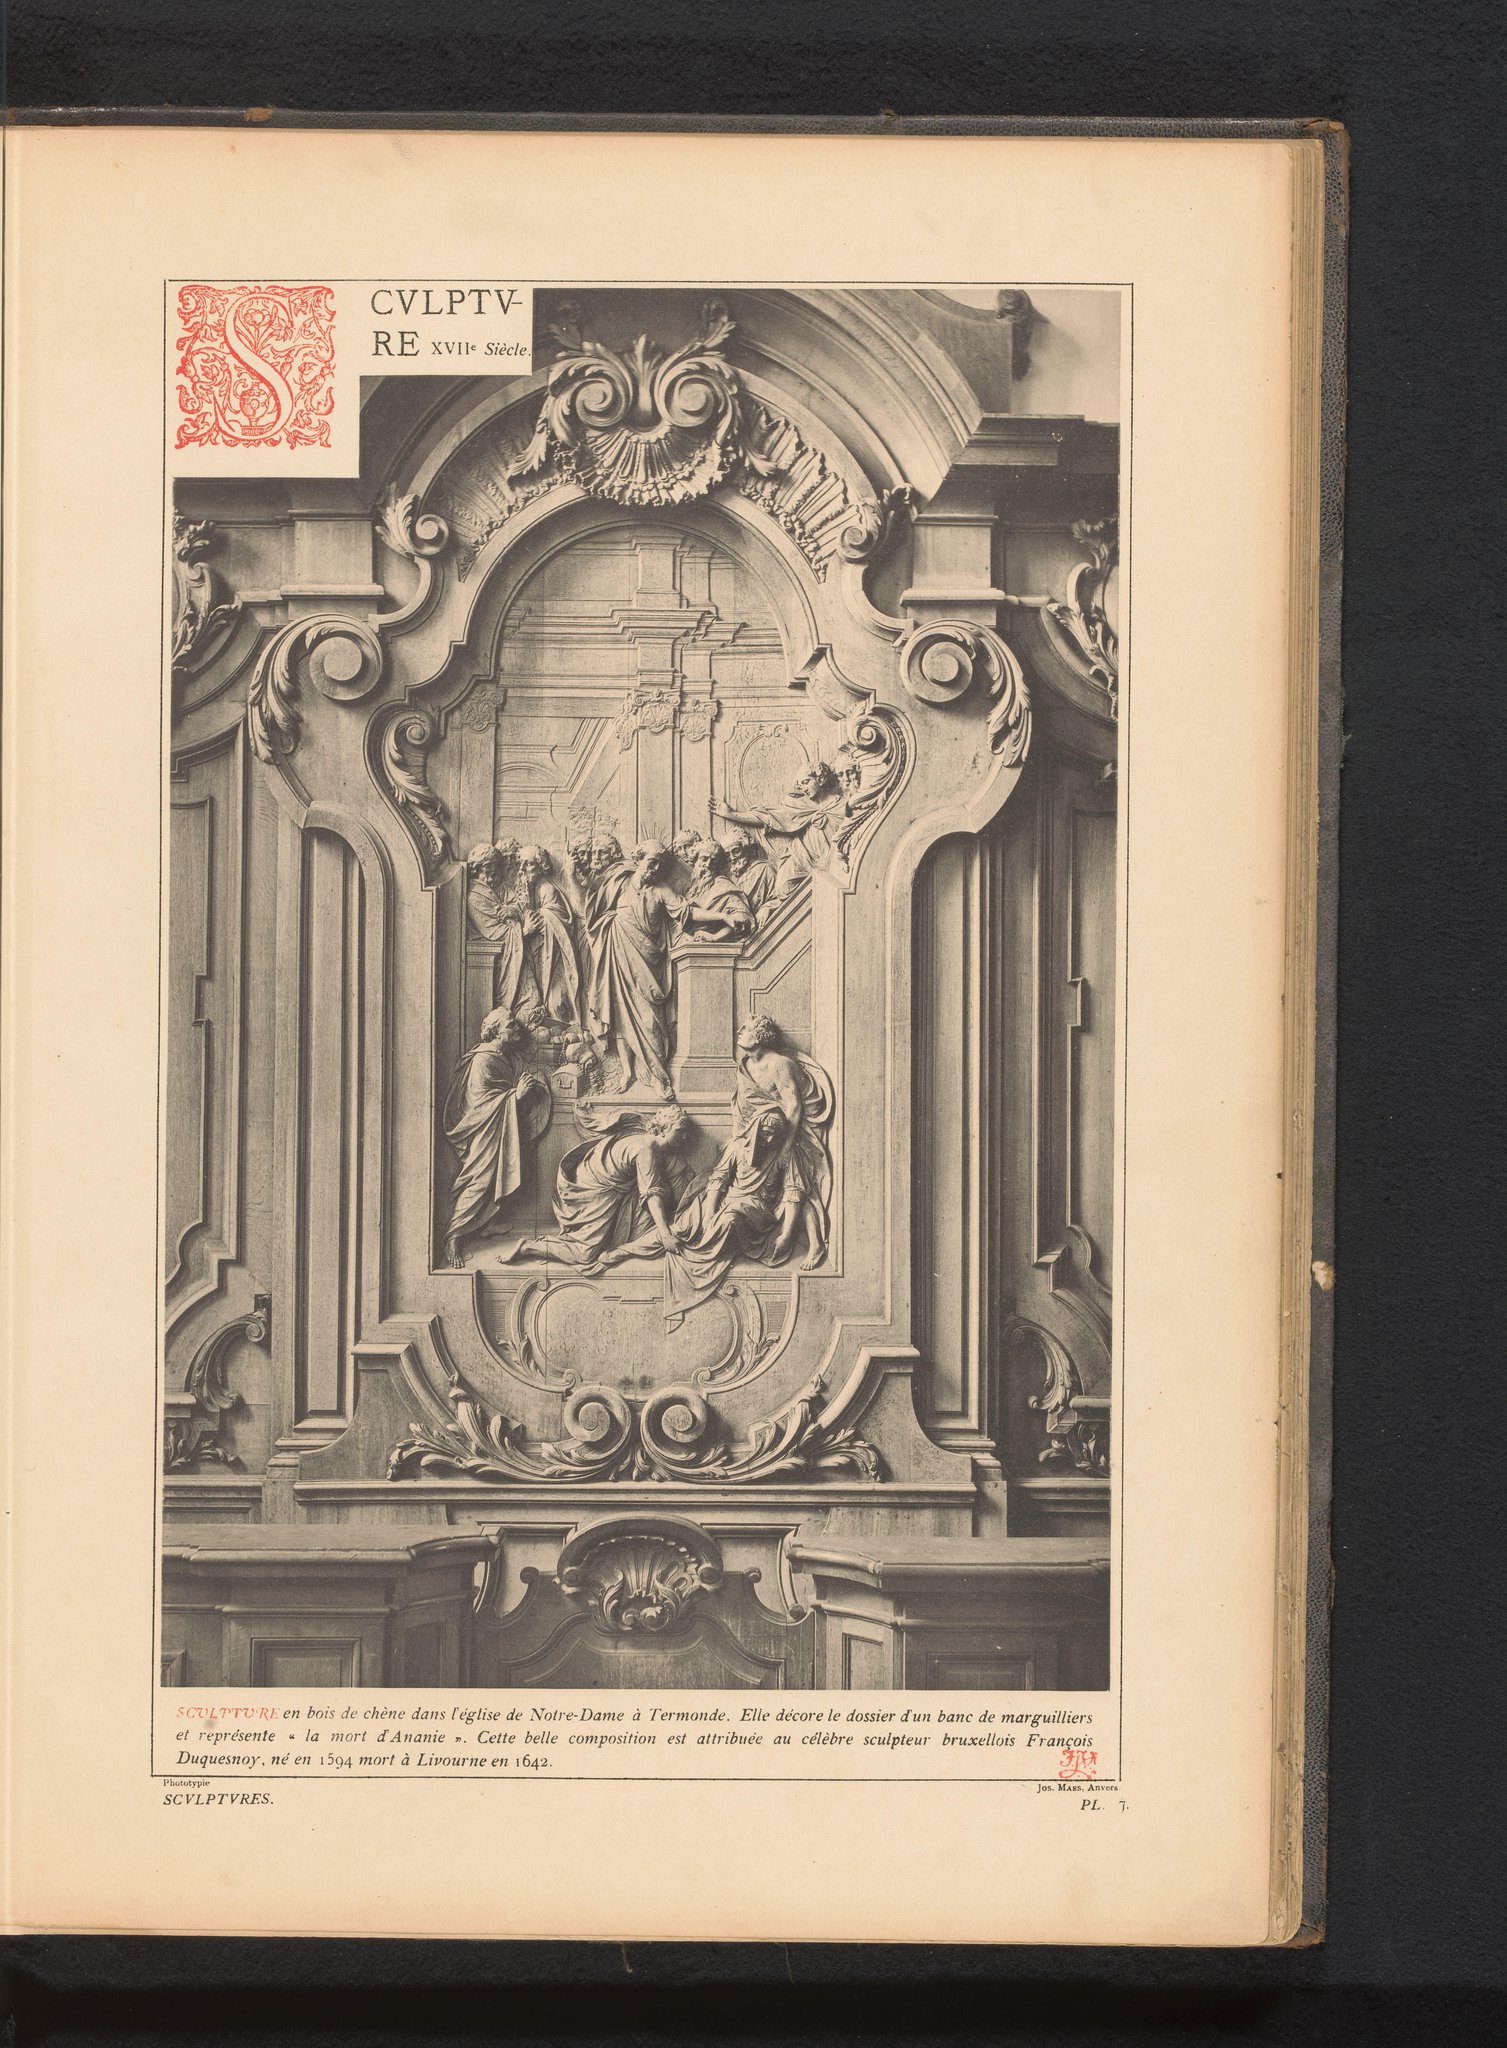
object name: page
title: Eikenhouten sculpturen in de Onze-Lieve-Vrouwekerk te Dendermonde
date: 1881-1889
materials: paper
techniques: photograph, photolithography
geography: dendermonde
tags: sculpture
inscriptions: inscription: ‘SCULPTURES. PL. 7.’, monogram: ‘JJvY’, inscription: ‘SCULPTURE en bois (...)’